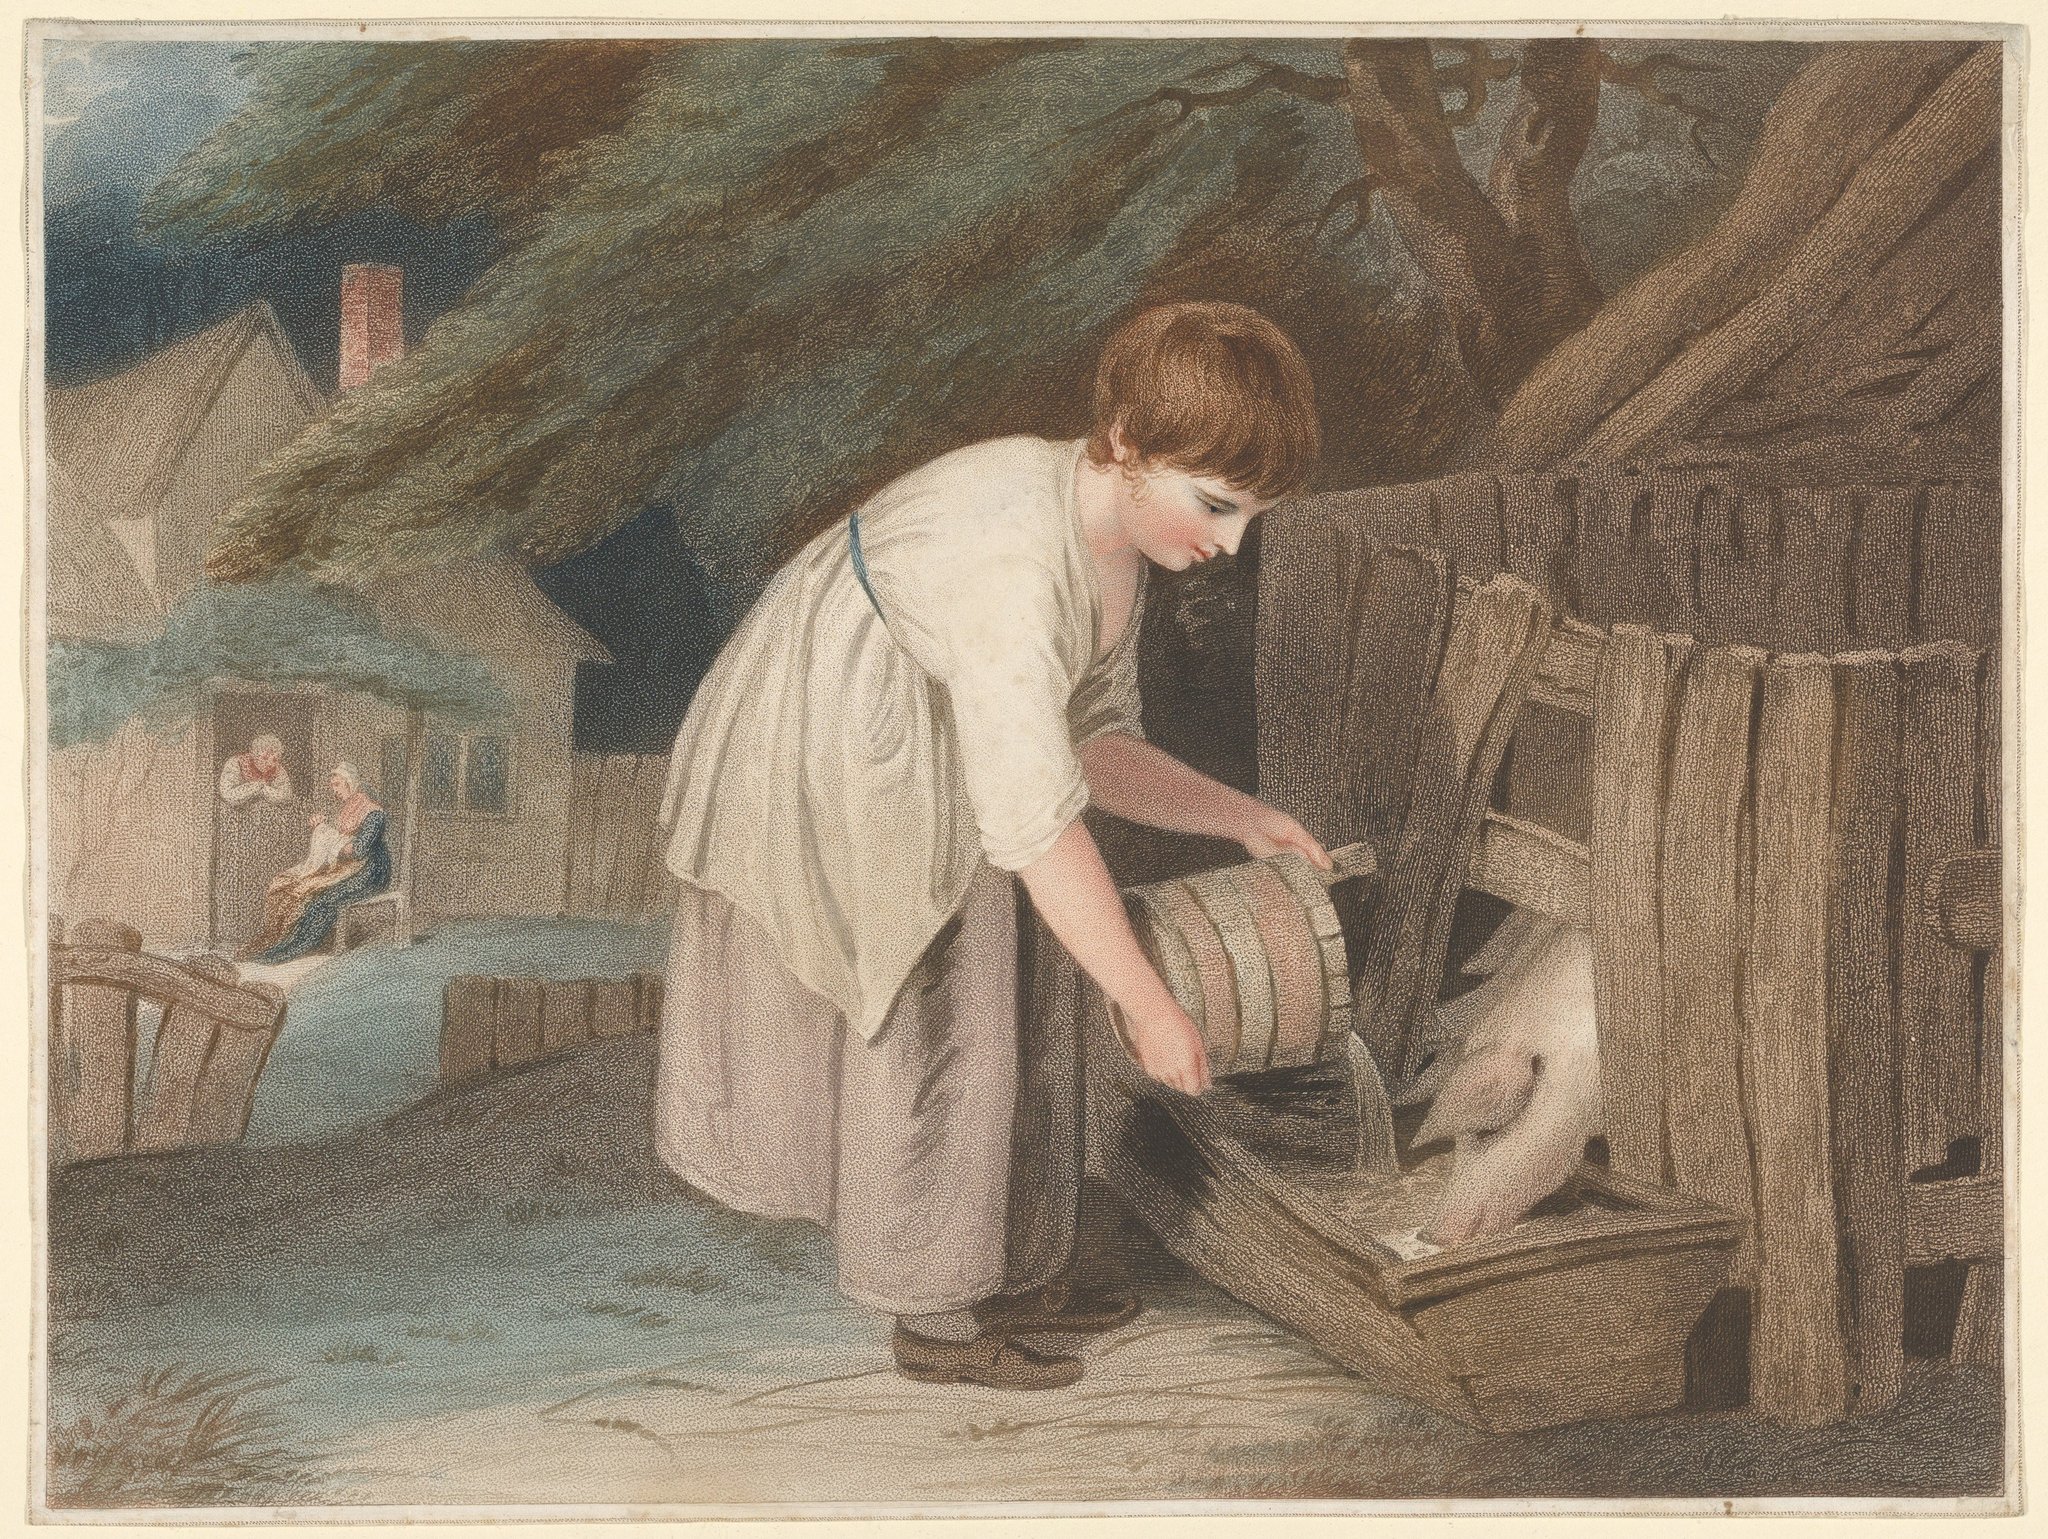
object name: print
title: Girl and Pigs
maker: thomas gaugain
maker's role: engraver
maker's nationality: british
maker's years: 1756-1810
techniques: printing, engraving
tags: girls,pigs